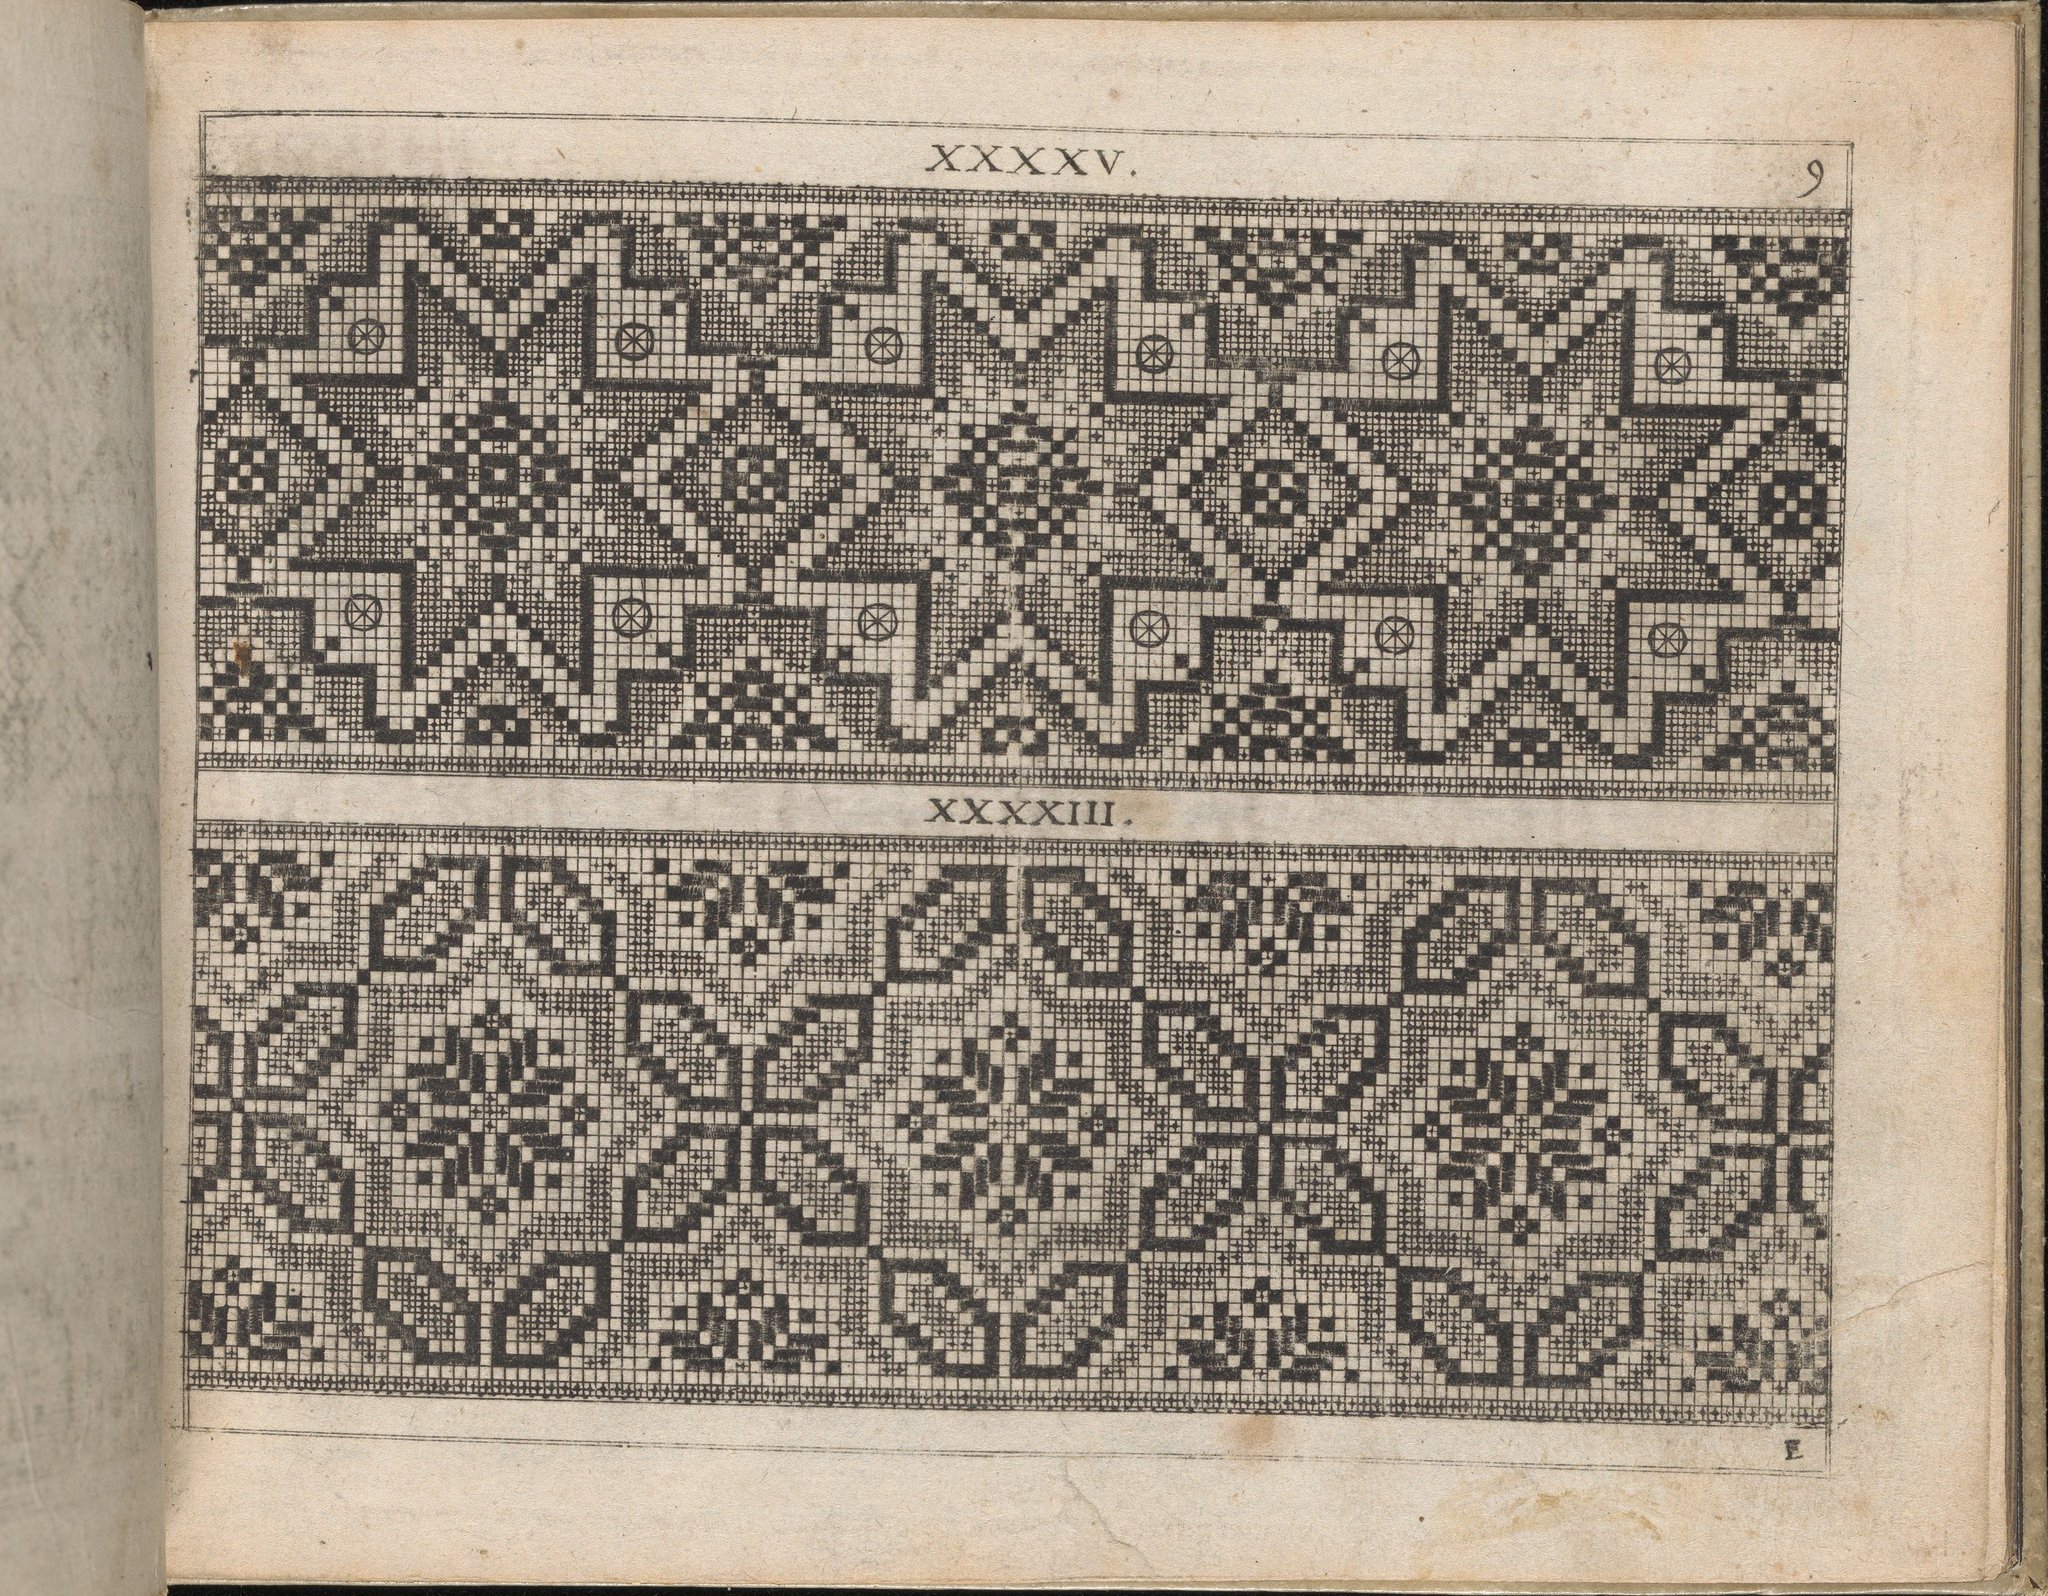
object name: book print ornament architecture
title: Newes Modelbuch in Kupffer (Page 18r)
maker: johann sibmacher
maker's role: artist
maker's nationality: german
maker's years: 1590-1611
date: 1604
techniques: etching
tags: ornament